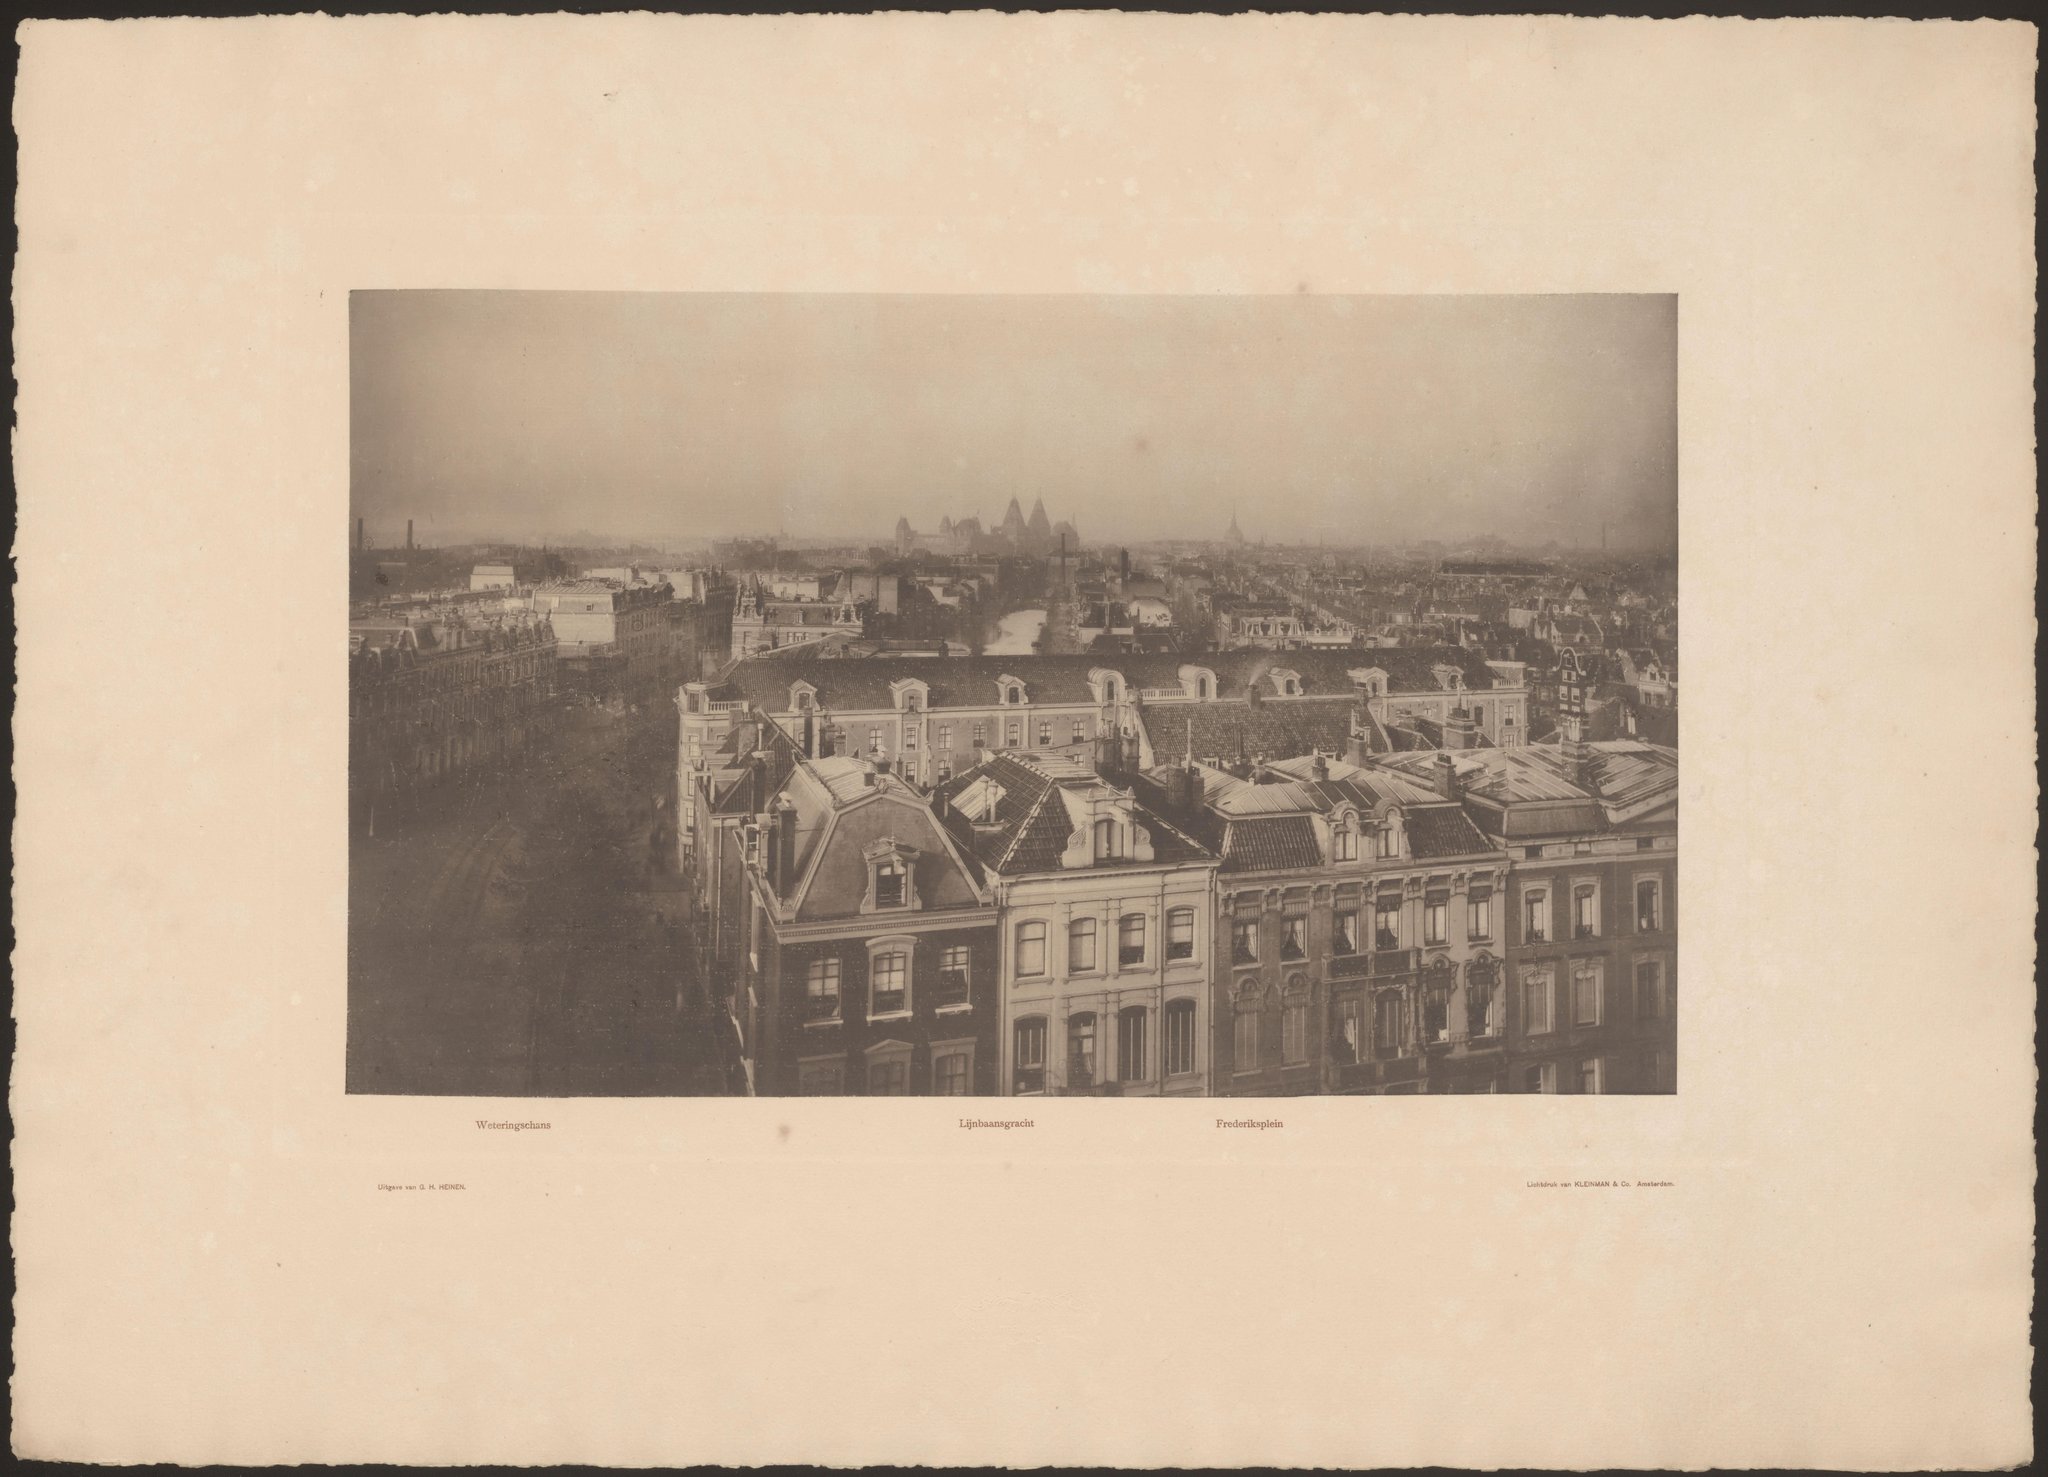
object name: photomechanical print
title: Gezicht op de Weteringschans en de Lijnbaansgracht vanaf het Frederiksplein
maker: gerrit hendricus heinen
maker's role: painter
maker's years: 1851-1930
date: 1892-1930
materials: paper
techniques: photograph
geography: amsterdam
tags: canal, permanent exhibition, museum, street, prospect of city, town panorama, silhouette of city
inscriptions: check stamp: ‘G.H. Heinen Amsterdam / Schilder & Fotograaf’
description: Onderwerpsrubriek binnen de Atlas Amsterdam: Panorama's en verzamelprenten.